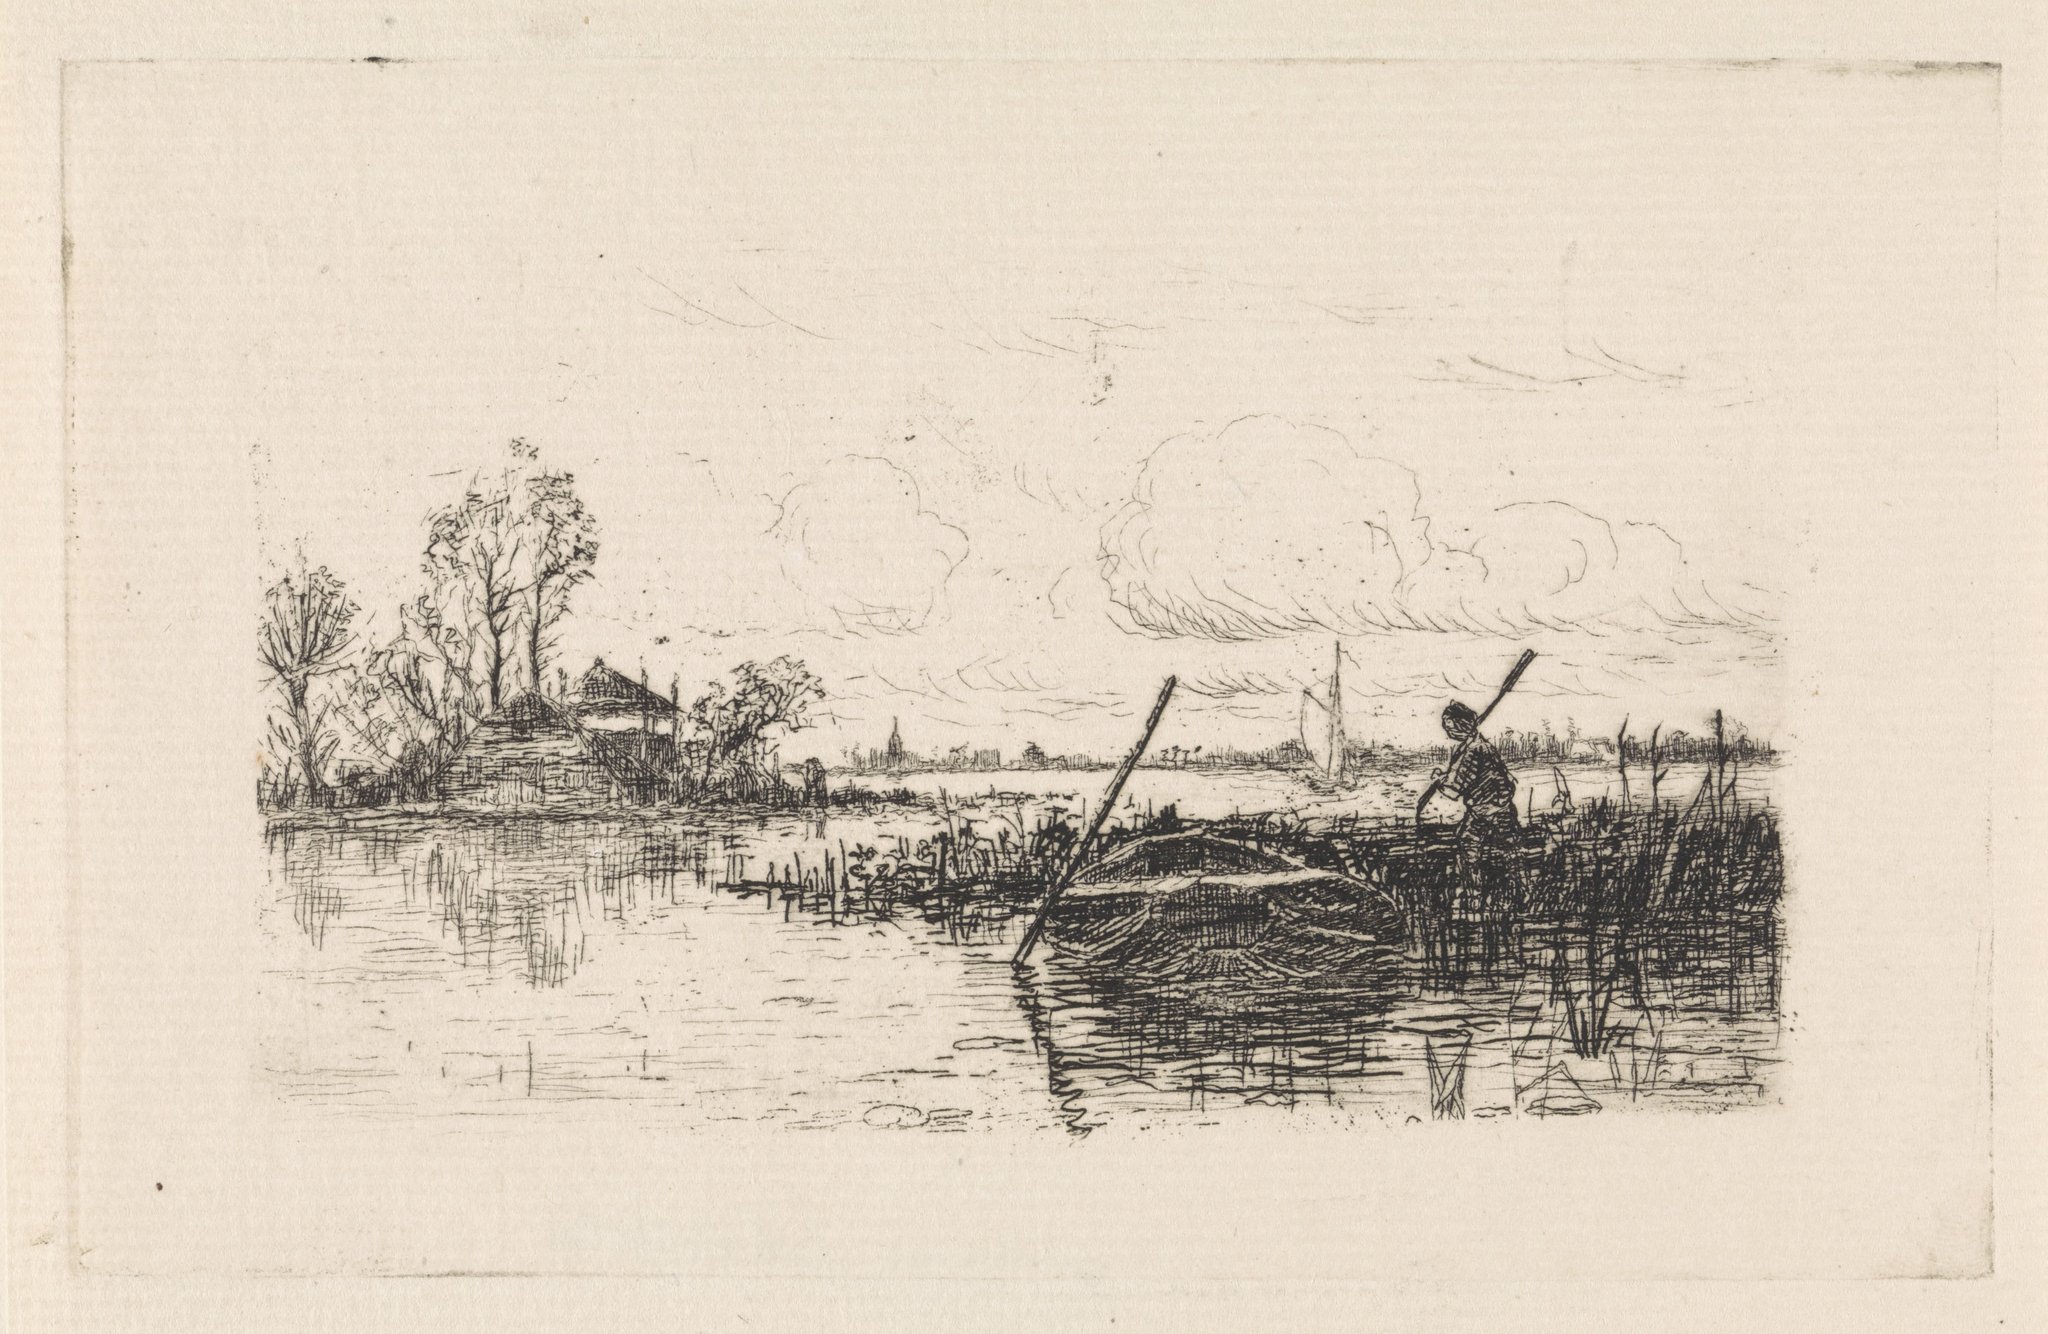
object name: print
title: Landschap met een man bij een roeiboot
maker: elias stark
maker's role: draughtsman, print maker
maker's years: 1849-1933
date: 1859-1886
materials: paper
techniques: etching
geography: netherlands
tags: rowing-boat, canoe, etc.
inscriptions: collector's mark: Lugt 2228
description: Een man loopt met een roeispaan over zijn schouder naar een roeiboot. Links op de achtergrond een boerderij en een hooiberg.